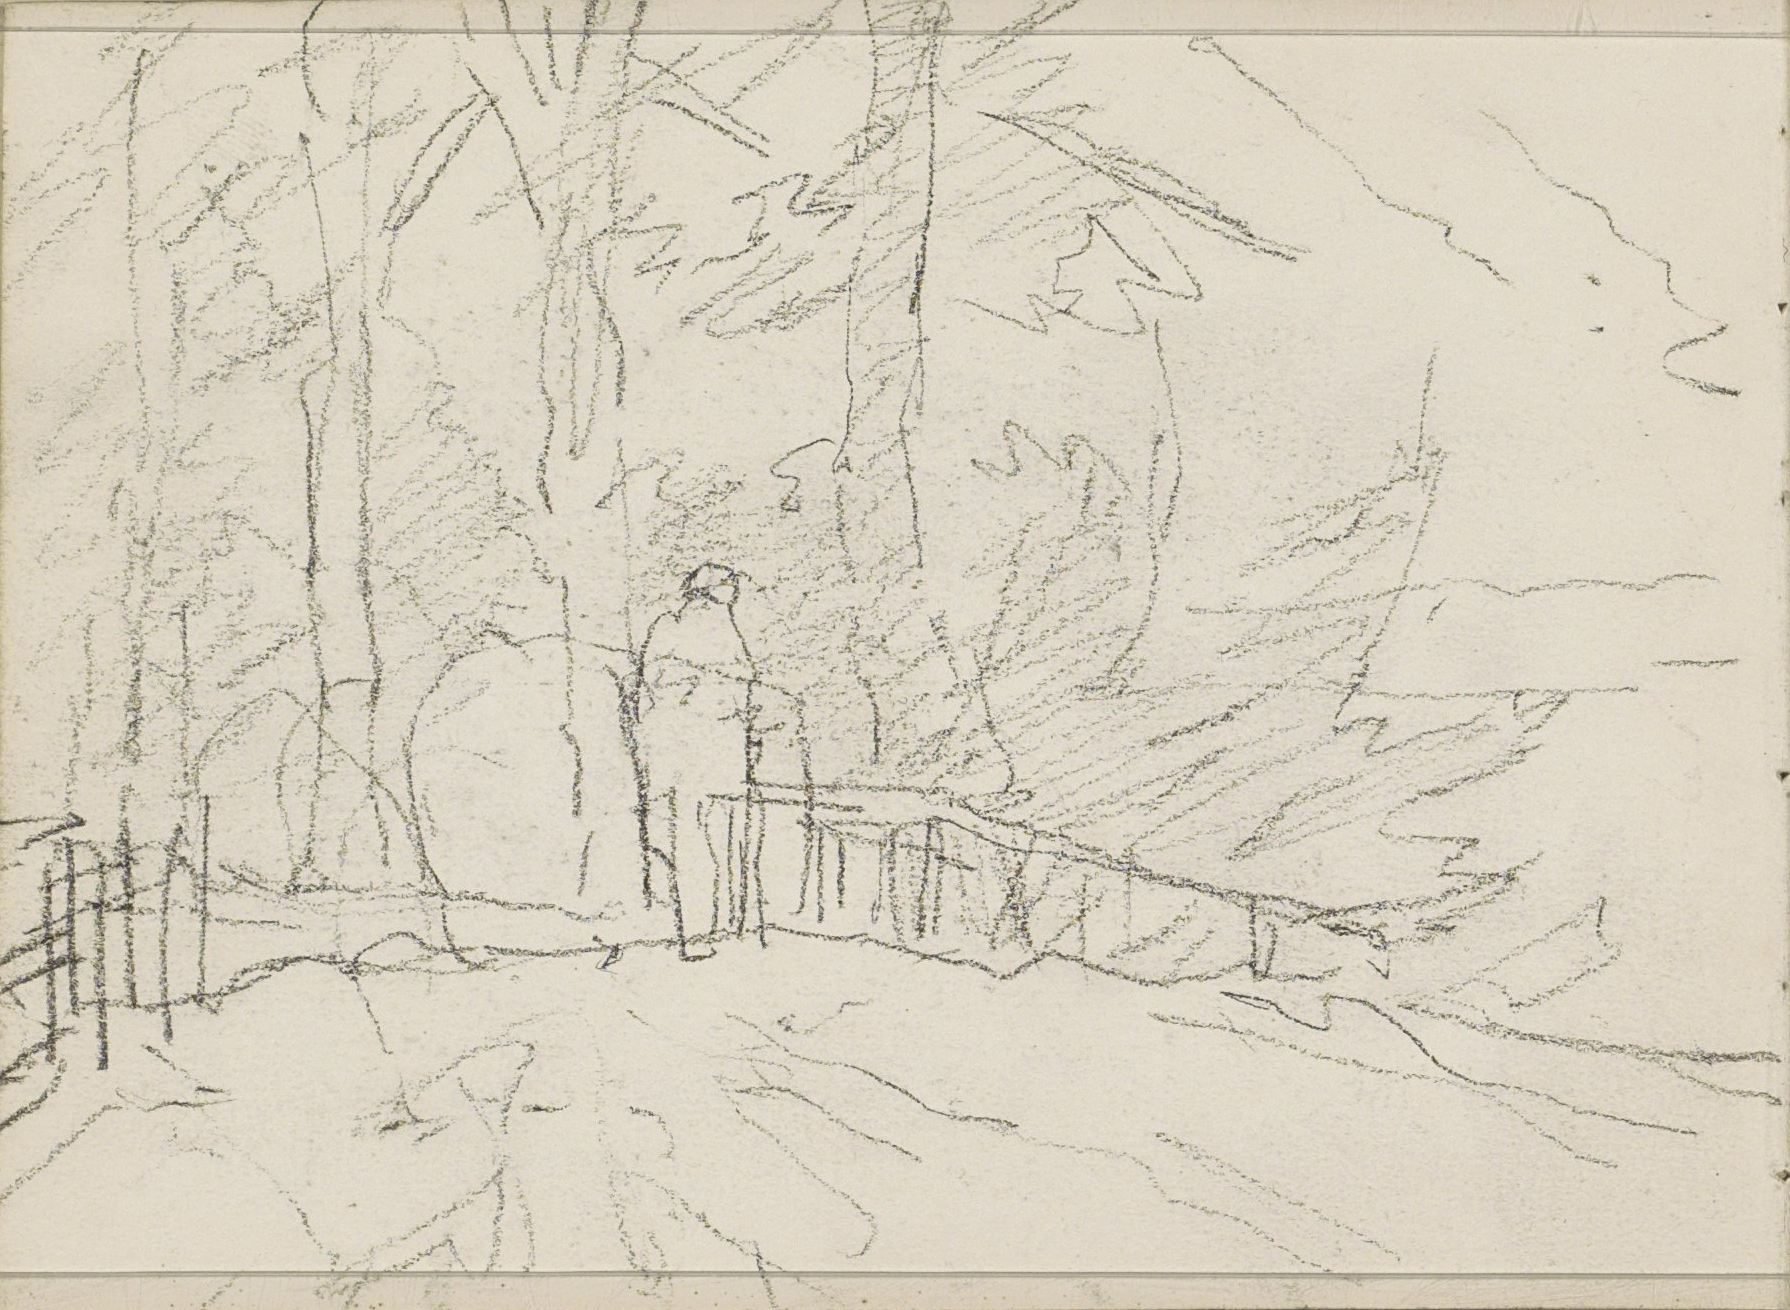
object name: sketchbook leaf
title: Staande figuur op een pad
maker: anton mauve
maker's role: draughtsman, painter, print maker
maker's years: 1838-1888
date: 1848-1888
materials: chalk, paper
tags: road, path, landscapes (+ landscape with figures, staffage)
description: Op de achtergrond een bos. Blad 24 verso uit een schetsboek met 33 bladen.